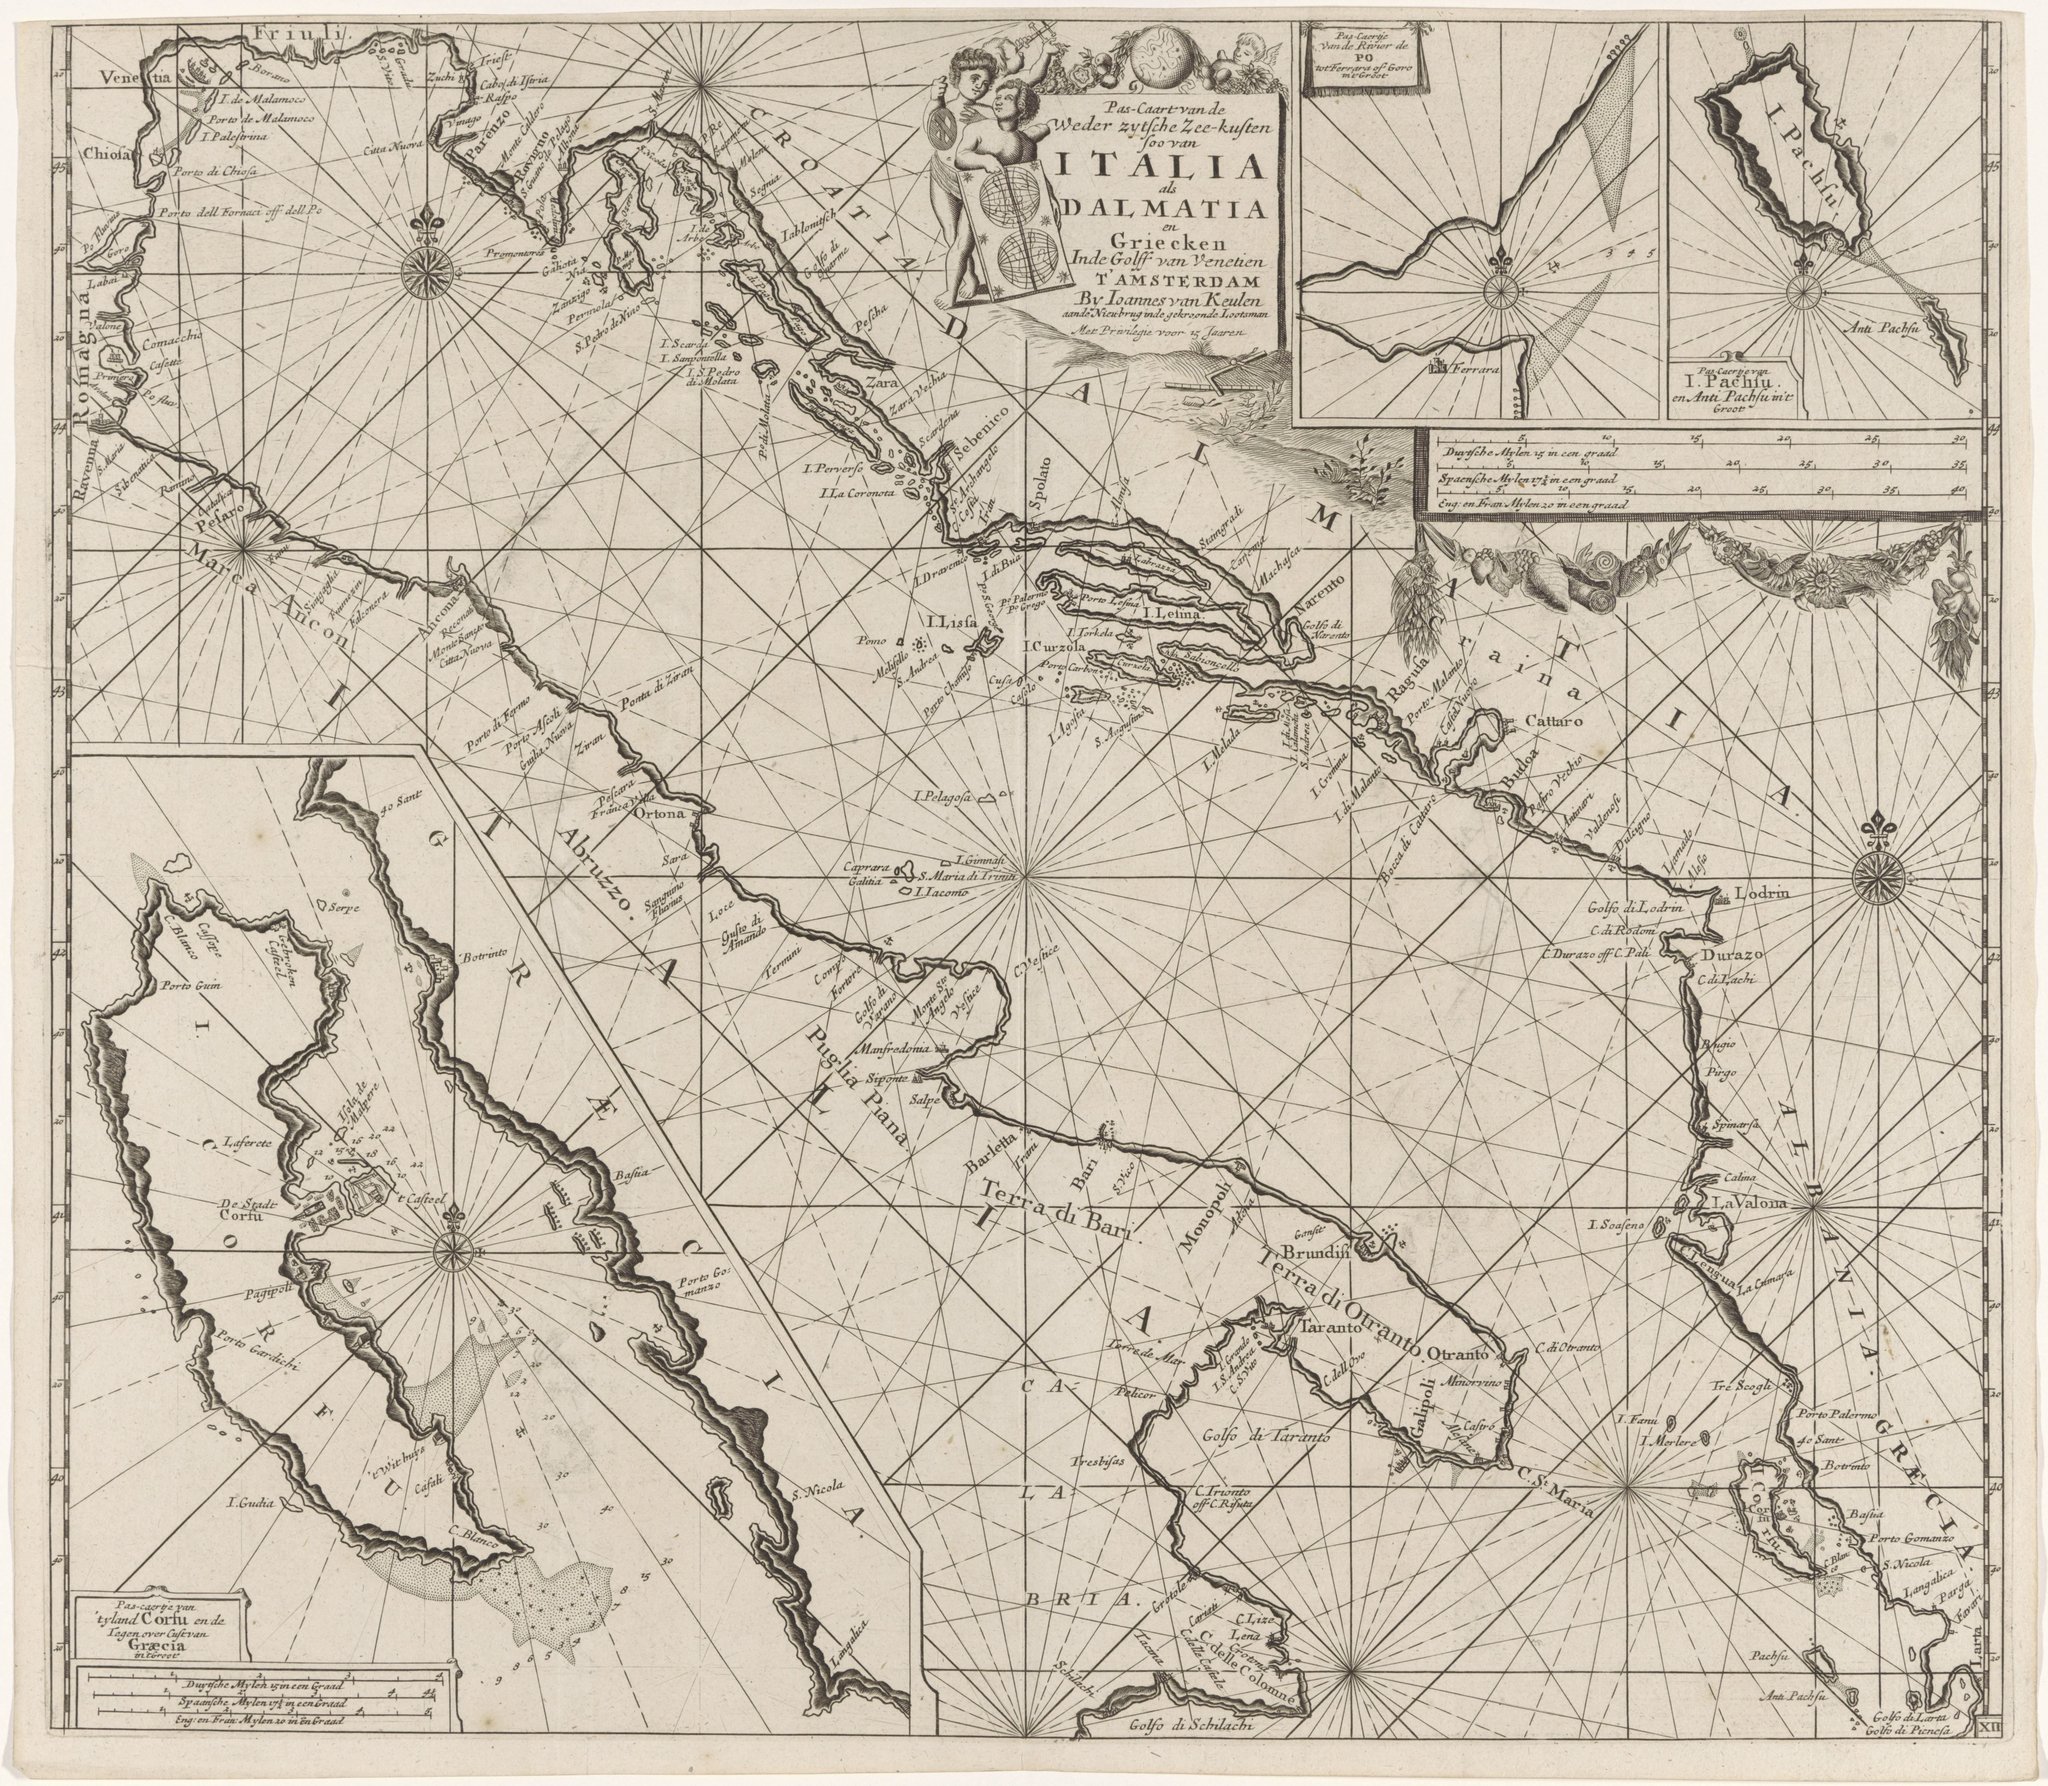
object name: print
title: Pas-Caart van de Weder zytsche Zee-kusten soo van Italia als Dalmatia en Griecken In de Golff van Venetien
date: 1682-1803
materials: paper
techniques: engraving, etching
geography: amsterdam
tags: maps, atlases, cupids: 'amores', 'amoretti', 'putti'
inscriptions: collector's mark: Lugt 2228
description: Kaart van de kusten van de Adriatische Zee, drie inzetkaarten; linksonder een van Corfu en rechtsboven een van de monding van de river de Po en een van het Ionische Eiland Paxoi. Met vijf kompasrozen, het Noorden ligt boven. Middenboven twee putti met een zeekaart bij de titel en het adres van de uitgever. Rechtsboven en linksonder de schaalverdeling, weergegeven in Duitse, Spaanse en Engelse of Franse mijlen.